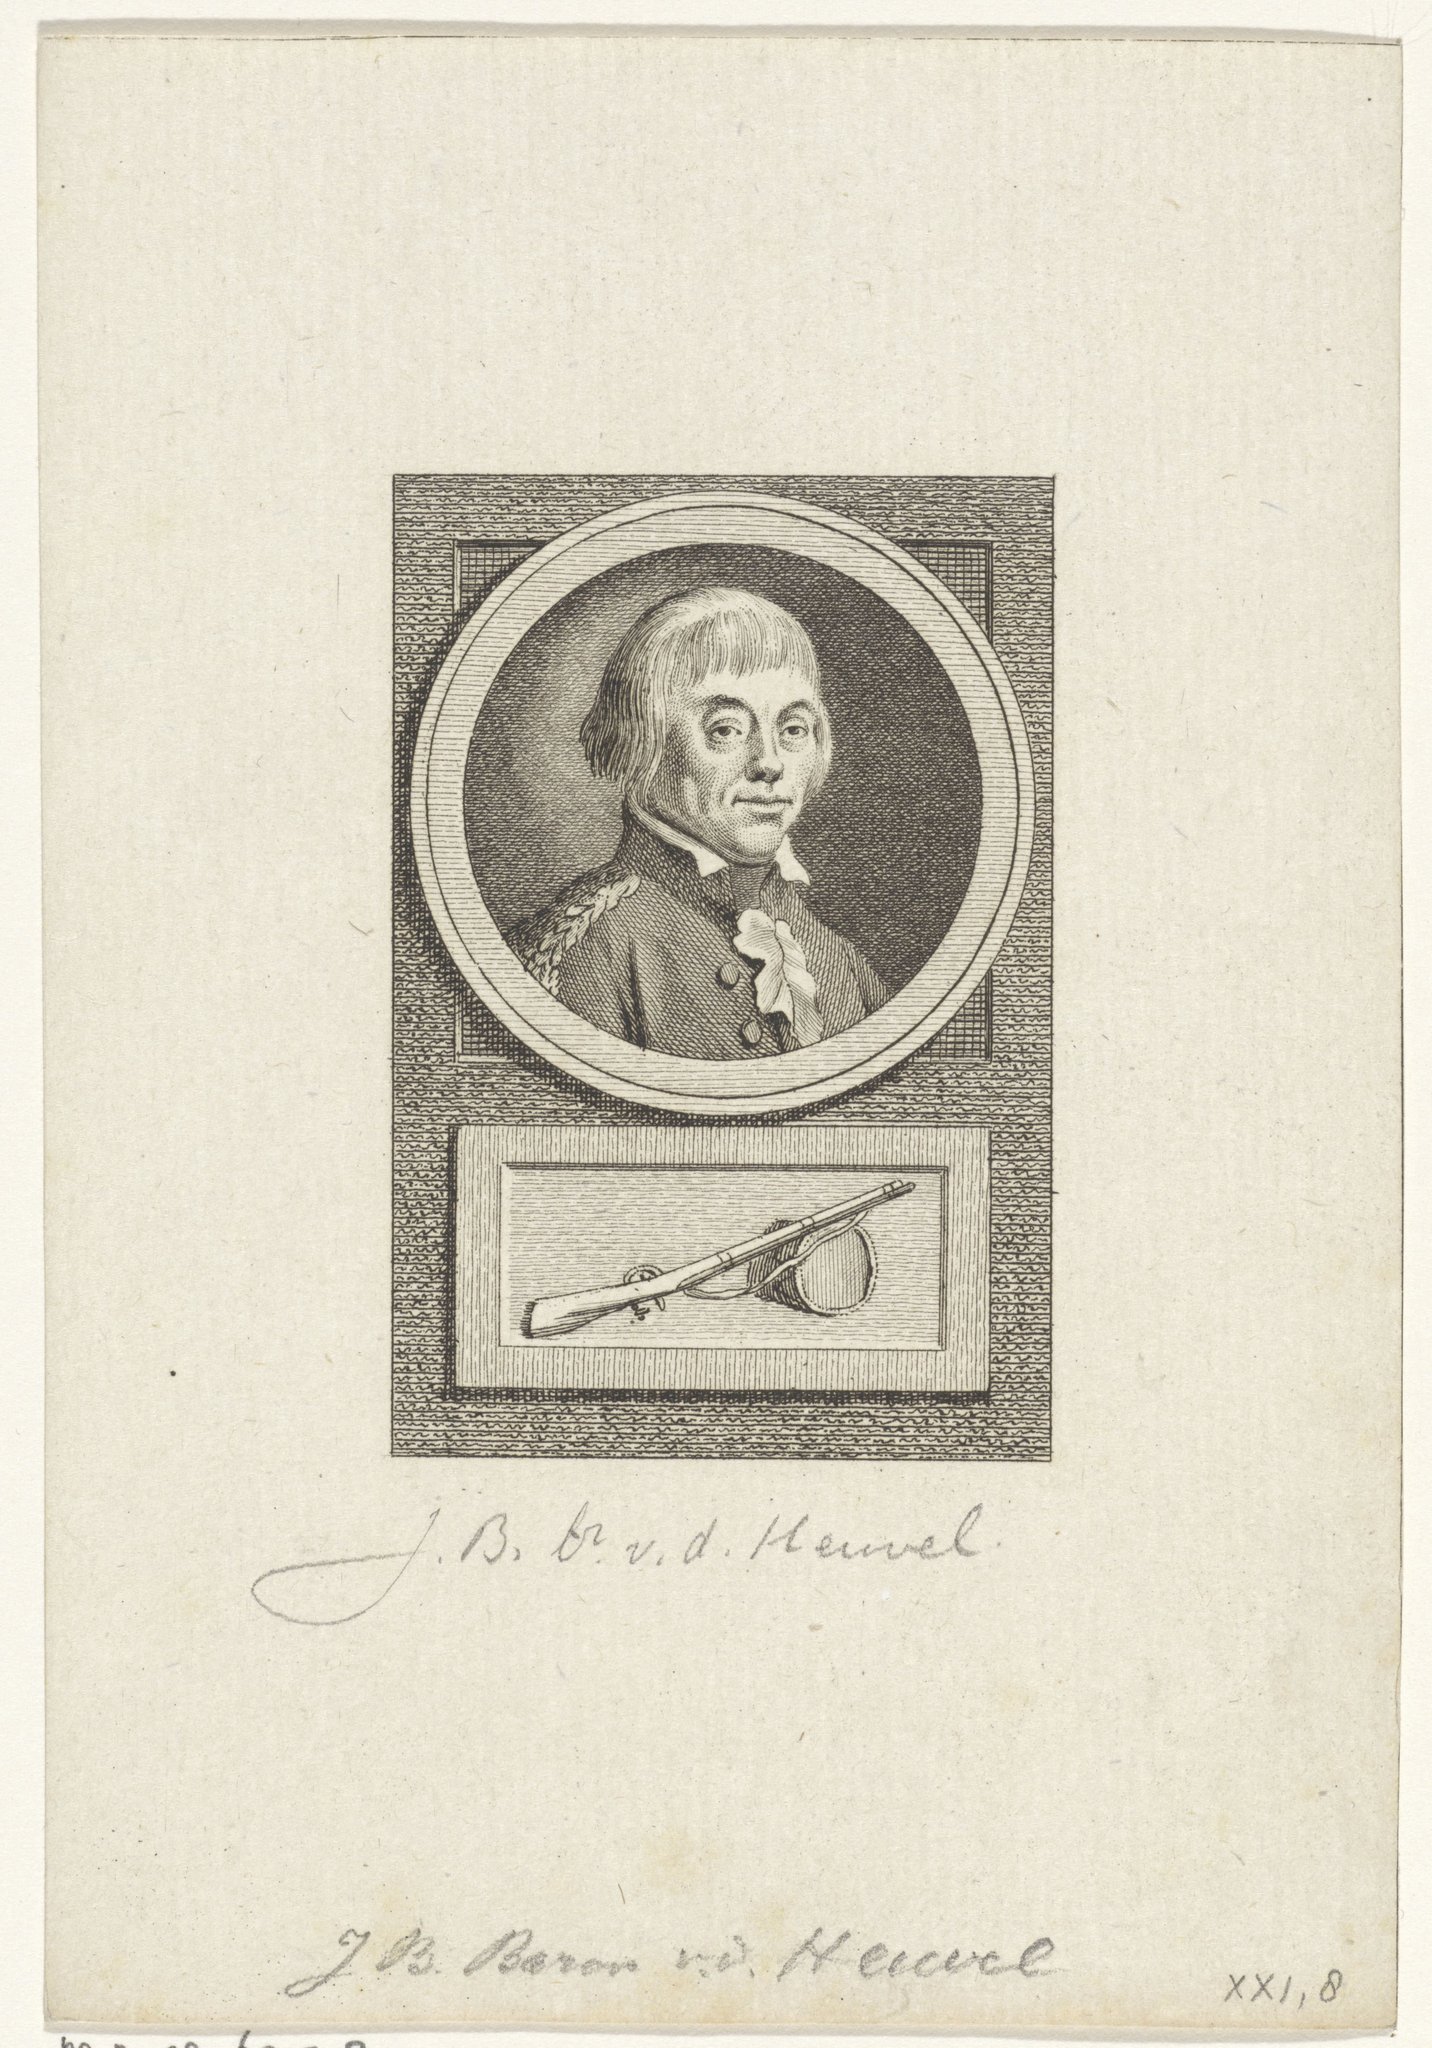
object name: print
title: Portret van Jan Baptist baron van den Heuvel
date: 1783-1795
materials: paper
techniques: engraving, etching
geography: amsterdam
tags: drum (musical instrument), firearms: rifle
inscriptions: collector's mark: Lugt 2228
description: Latere staat prent gebruikt in: Fokke, Jan. Geschiedenissen der Vereenigde Nederlanden voor de vaderlandsche jeugd Ie-XXVste deel. Amsterdam: Johannes Allart, 1783-1795. Deel XXI.